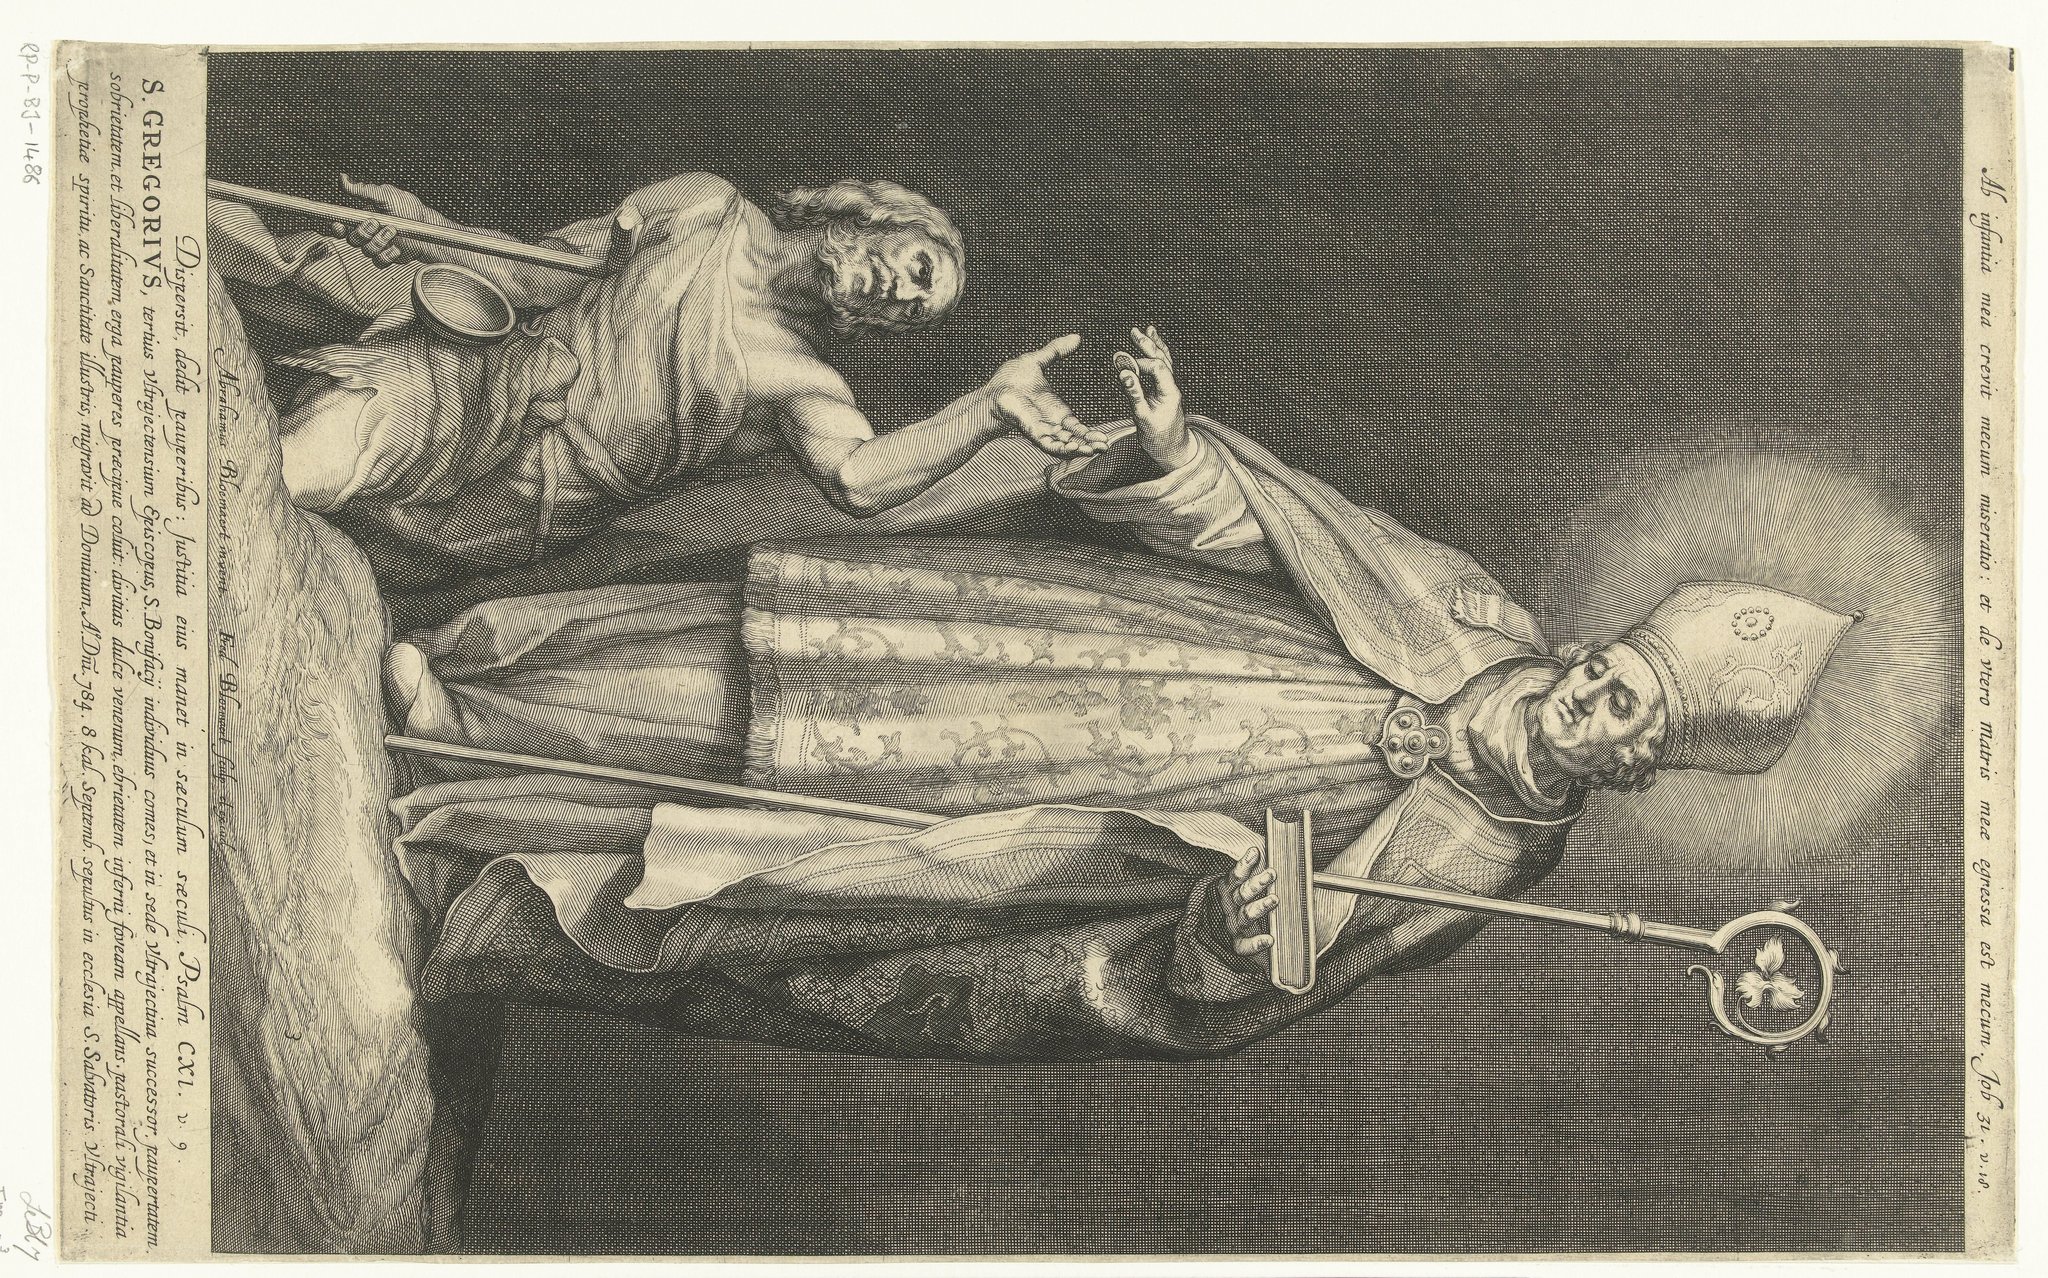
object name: print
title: Prelaten en bisschoppen van Utrecht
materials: paper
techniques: engraving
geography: utrecht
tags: heilige, gregorius van utrecht, merovingische en karolingische tijd in nederland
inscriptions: collector's mark: Lugt 240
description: De heilige Gregorius afgebeeld als een bisschop met geborduurde albe en kap, mijter en kromstaf die een arme man een aalmoes geeft. Met Latijns onderschrift. Prent uit een serie van twaalf prenten met prelaten en bisschoppen van Utrecht door Cornelis en Frederick Bloemaert.